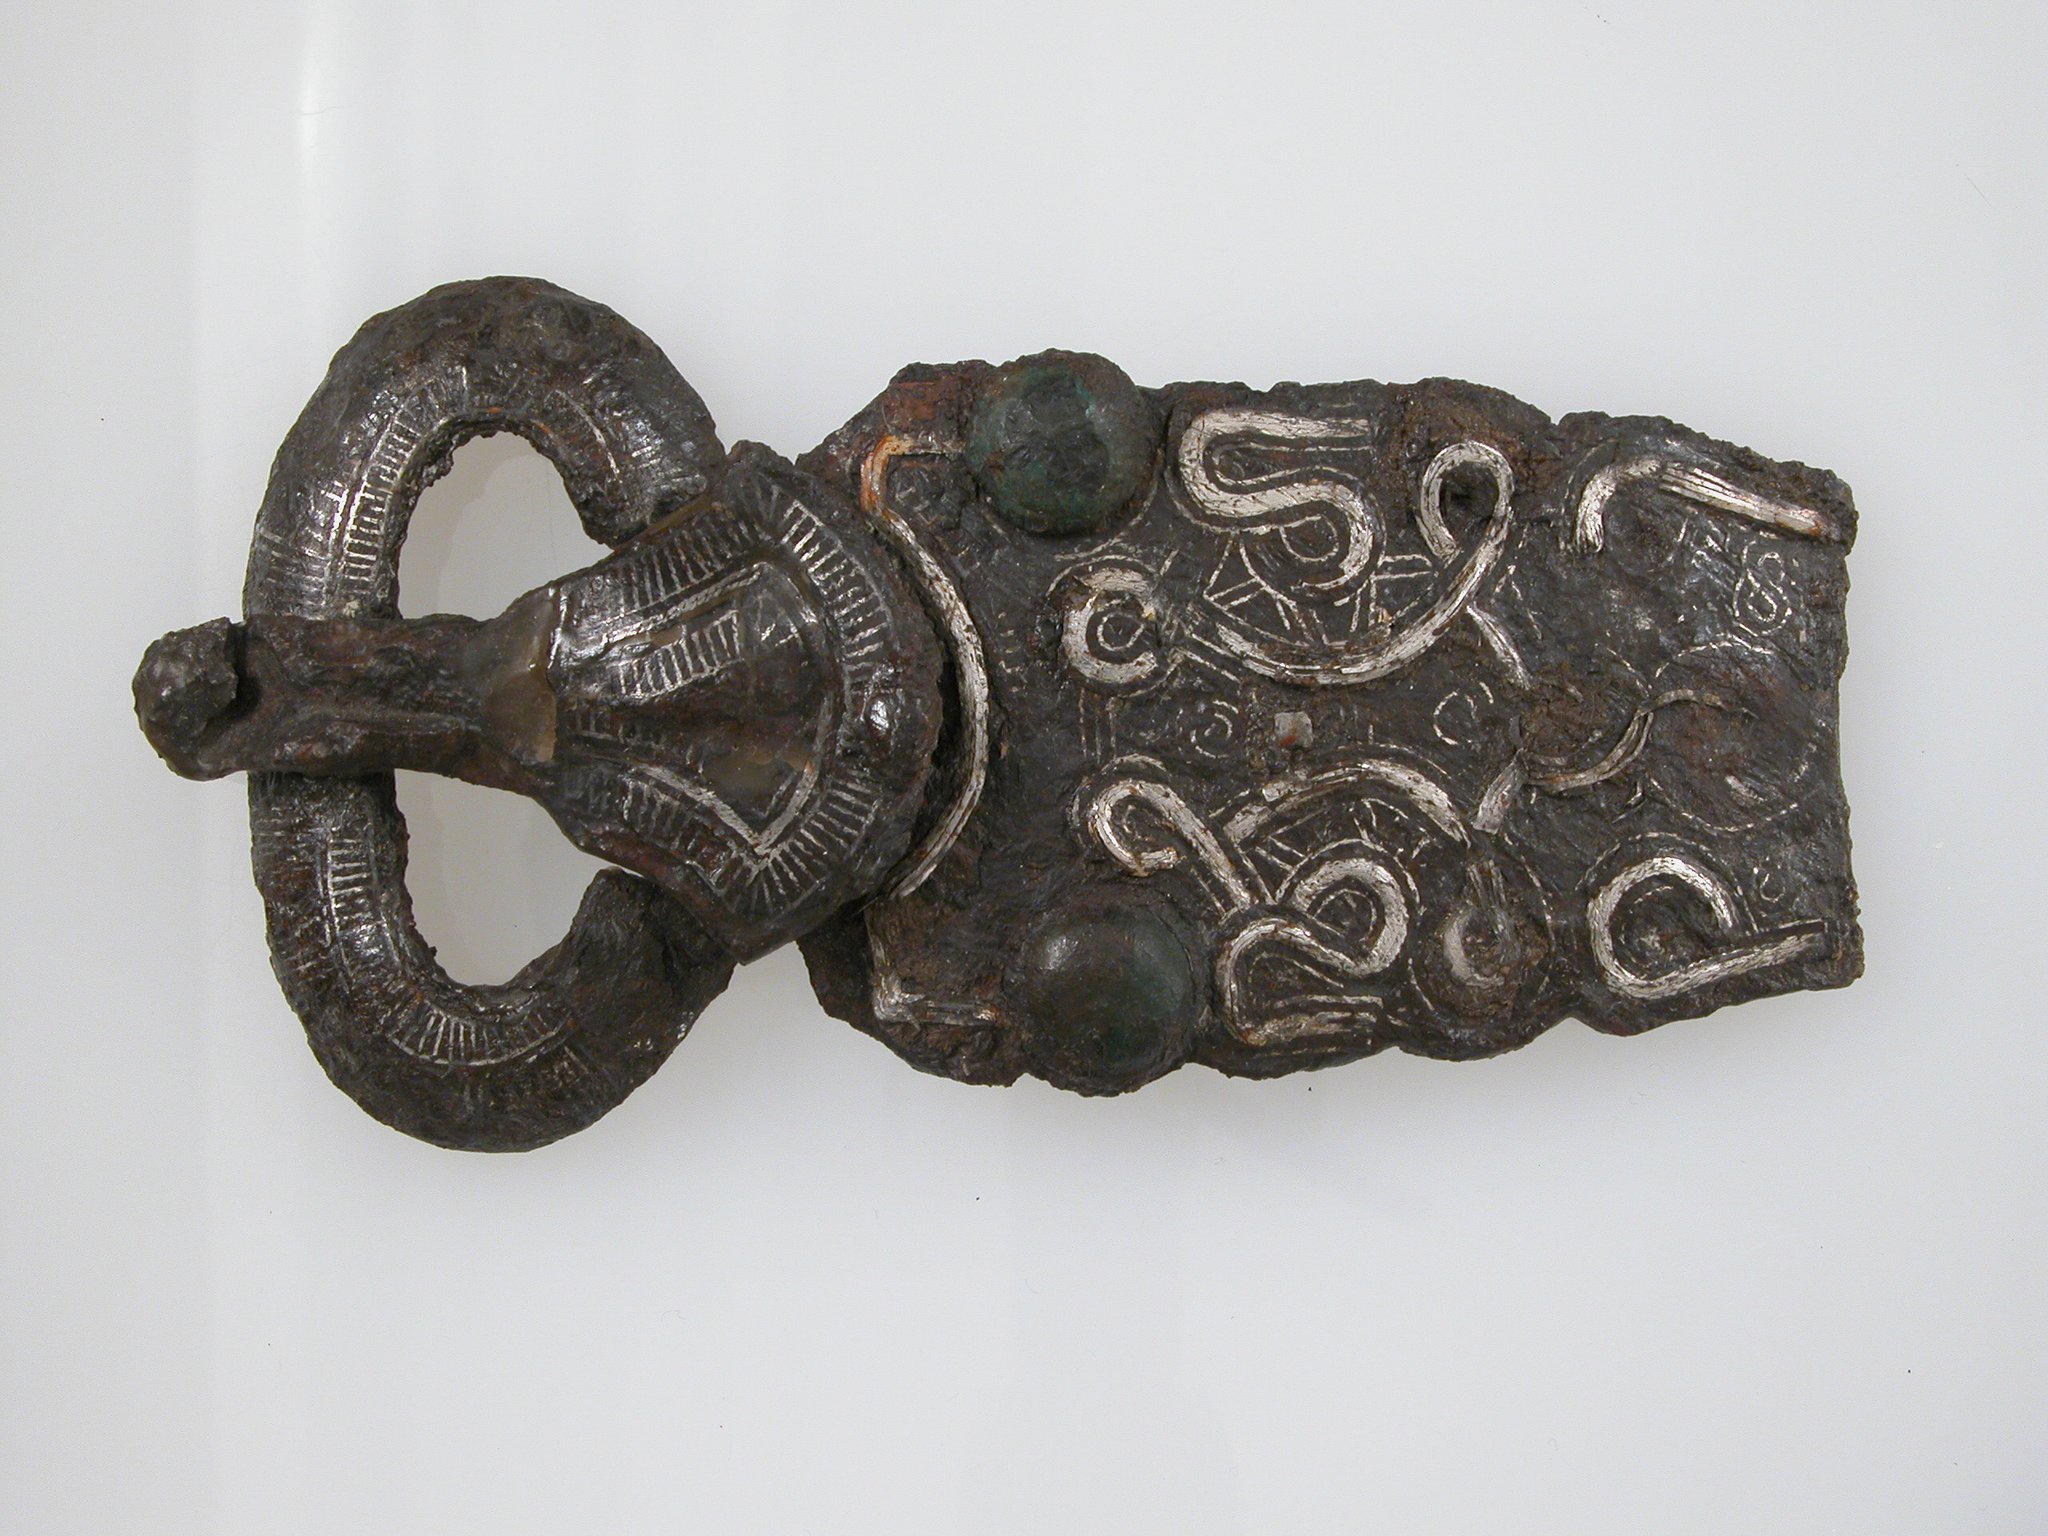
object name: belt buckle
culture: frankish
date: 601-700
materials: bronze, iron, silver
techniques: inlay